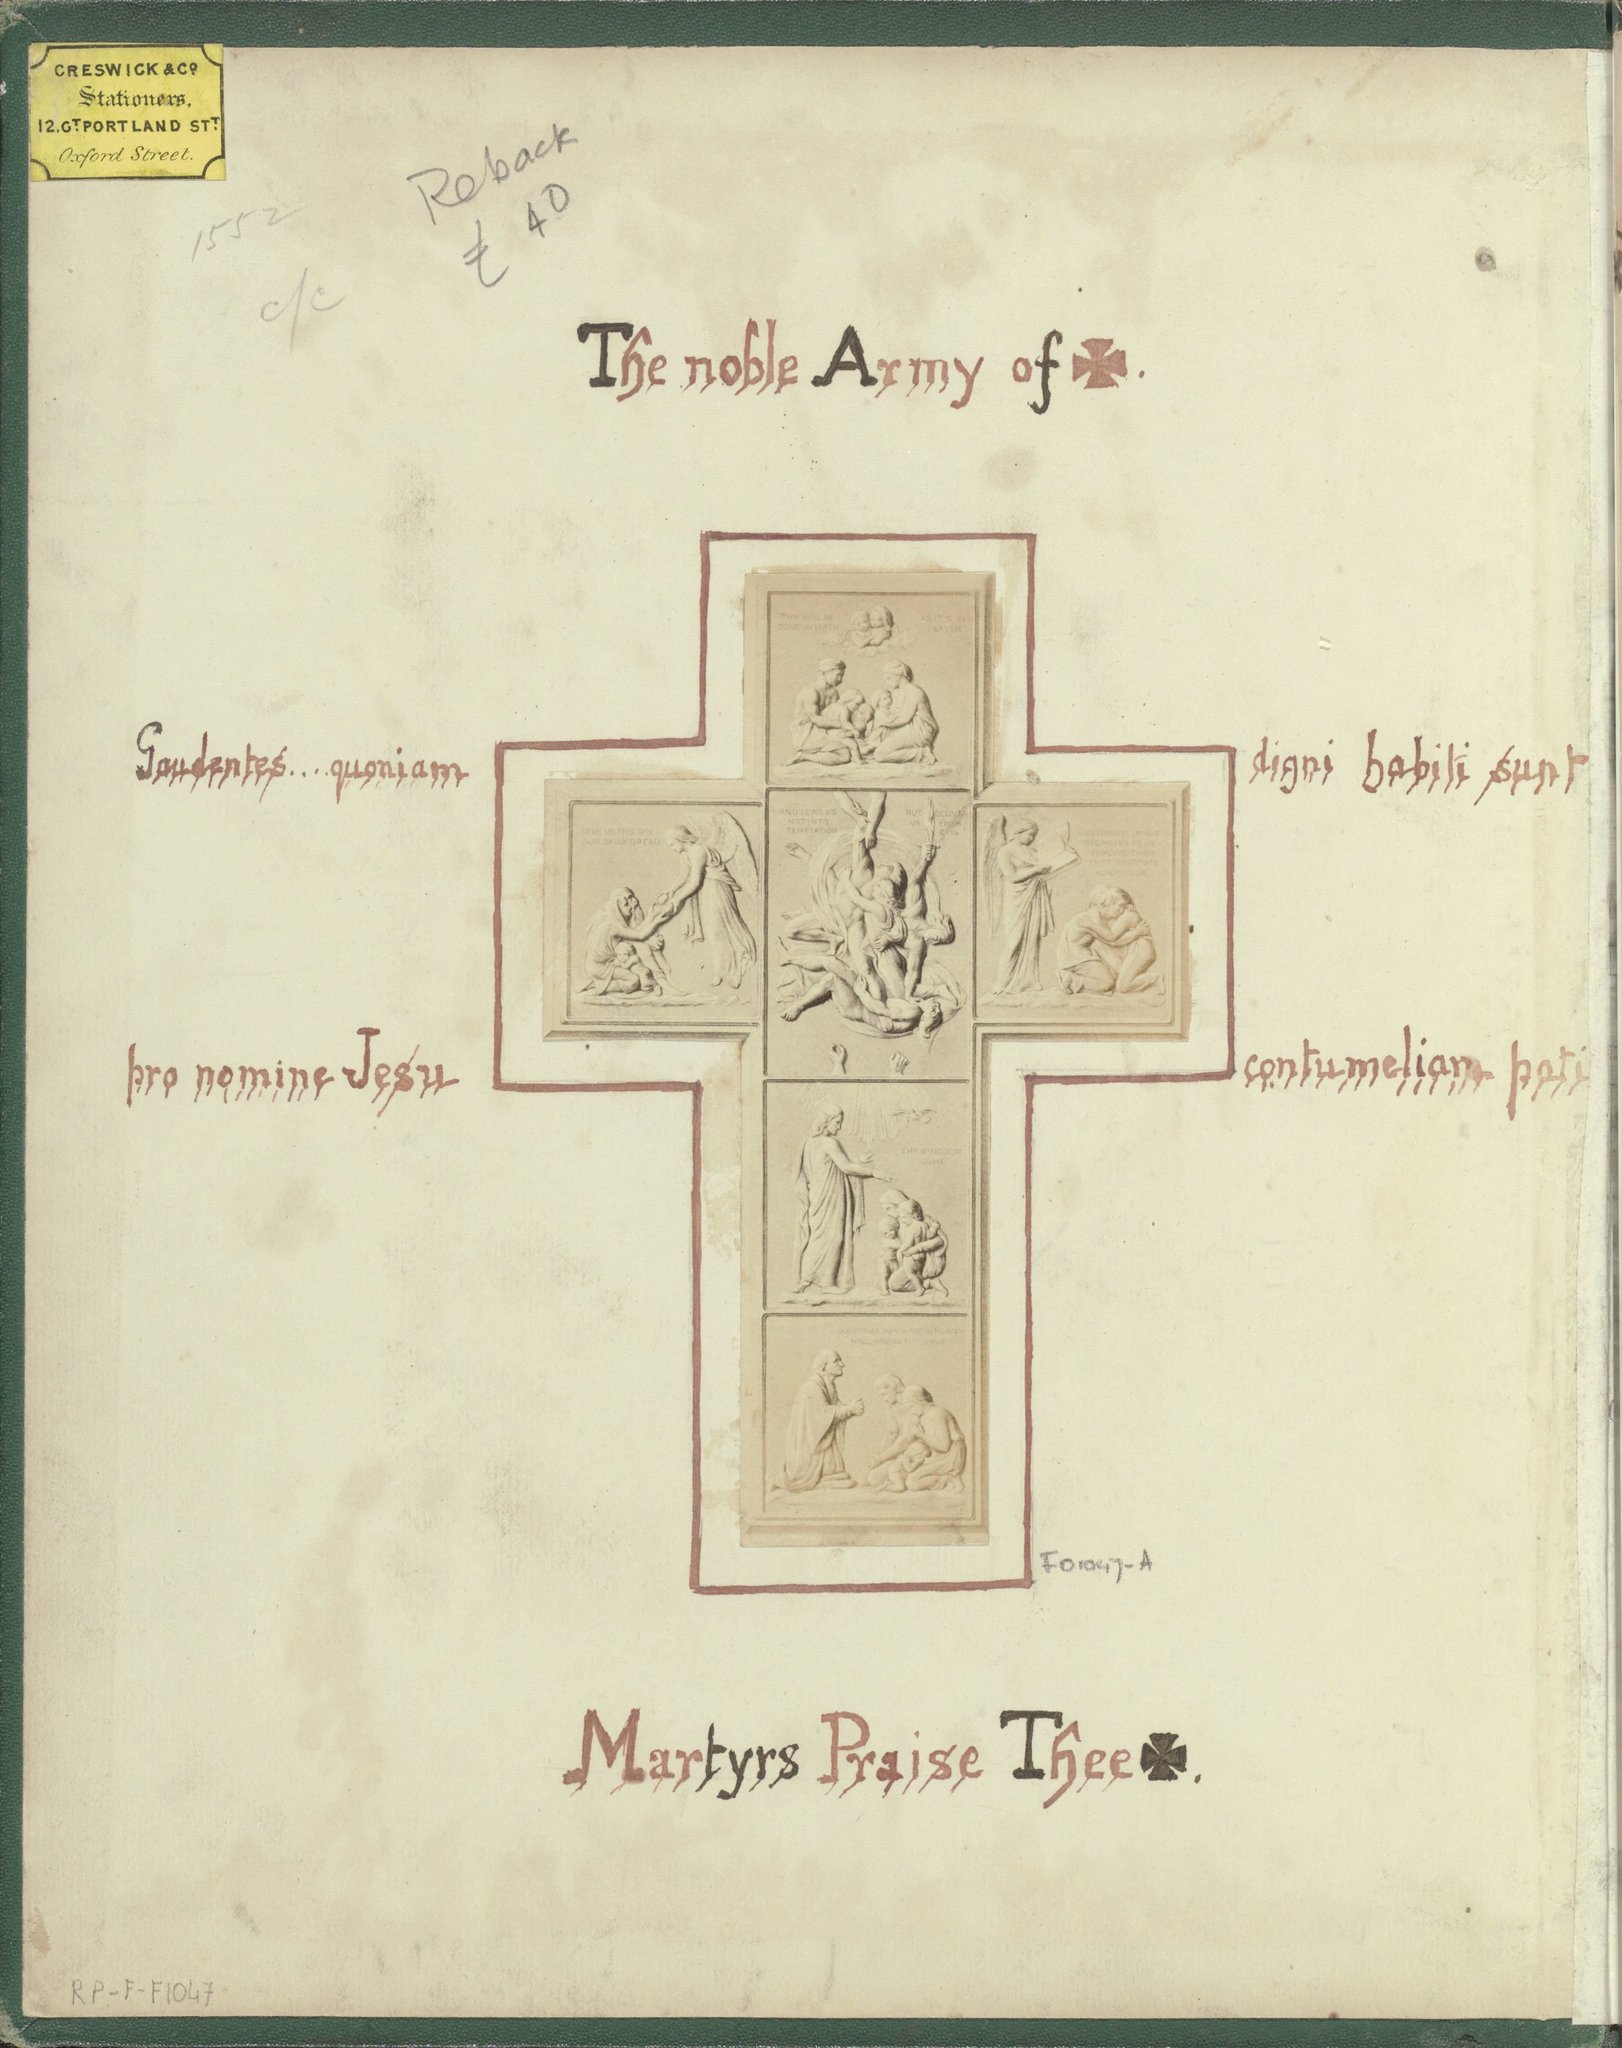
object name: reproduction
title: Reproductie van (vermoedelijk) een tekening van een kruis met zes uitgebeelde bijbelteksten, omgeven door Engelse en Latijnse tekst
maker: Anonymous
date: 1871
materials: cardboard, paper, photographic support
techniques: albumen print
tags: altarcross, crucifix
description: Onderdeel van Herdenkingsalbum van rooms-katholieke geestelijken gevallen tijdens de Commune van Parijs.